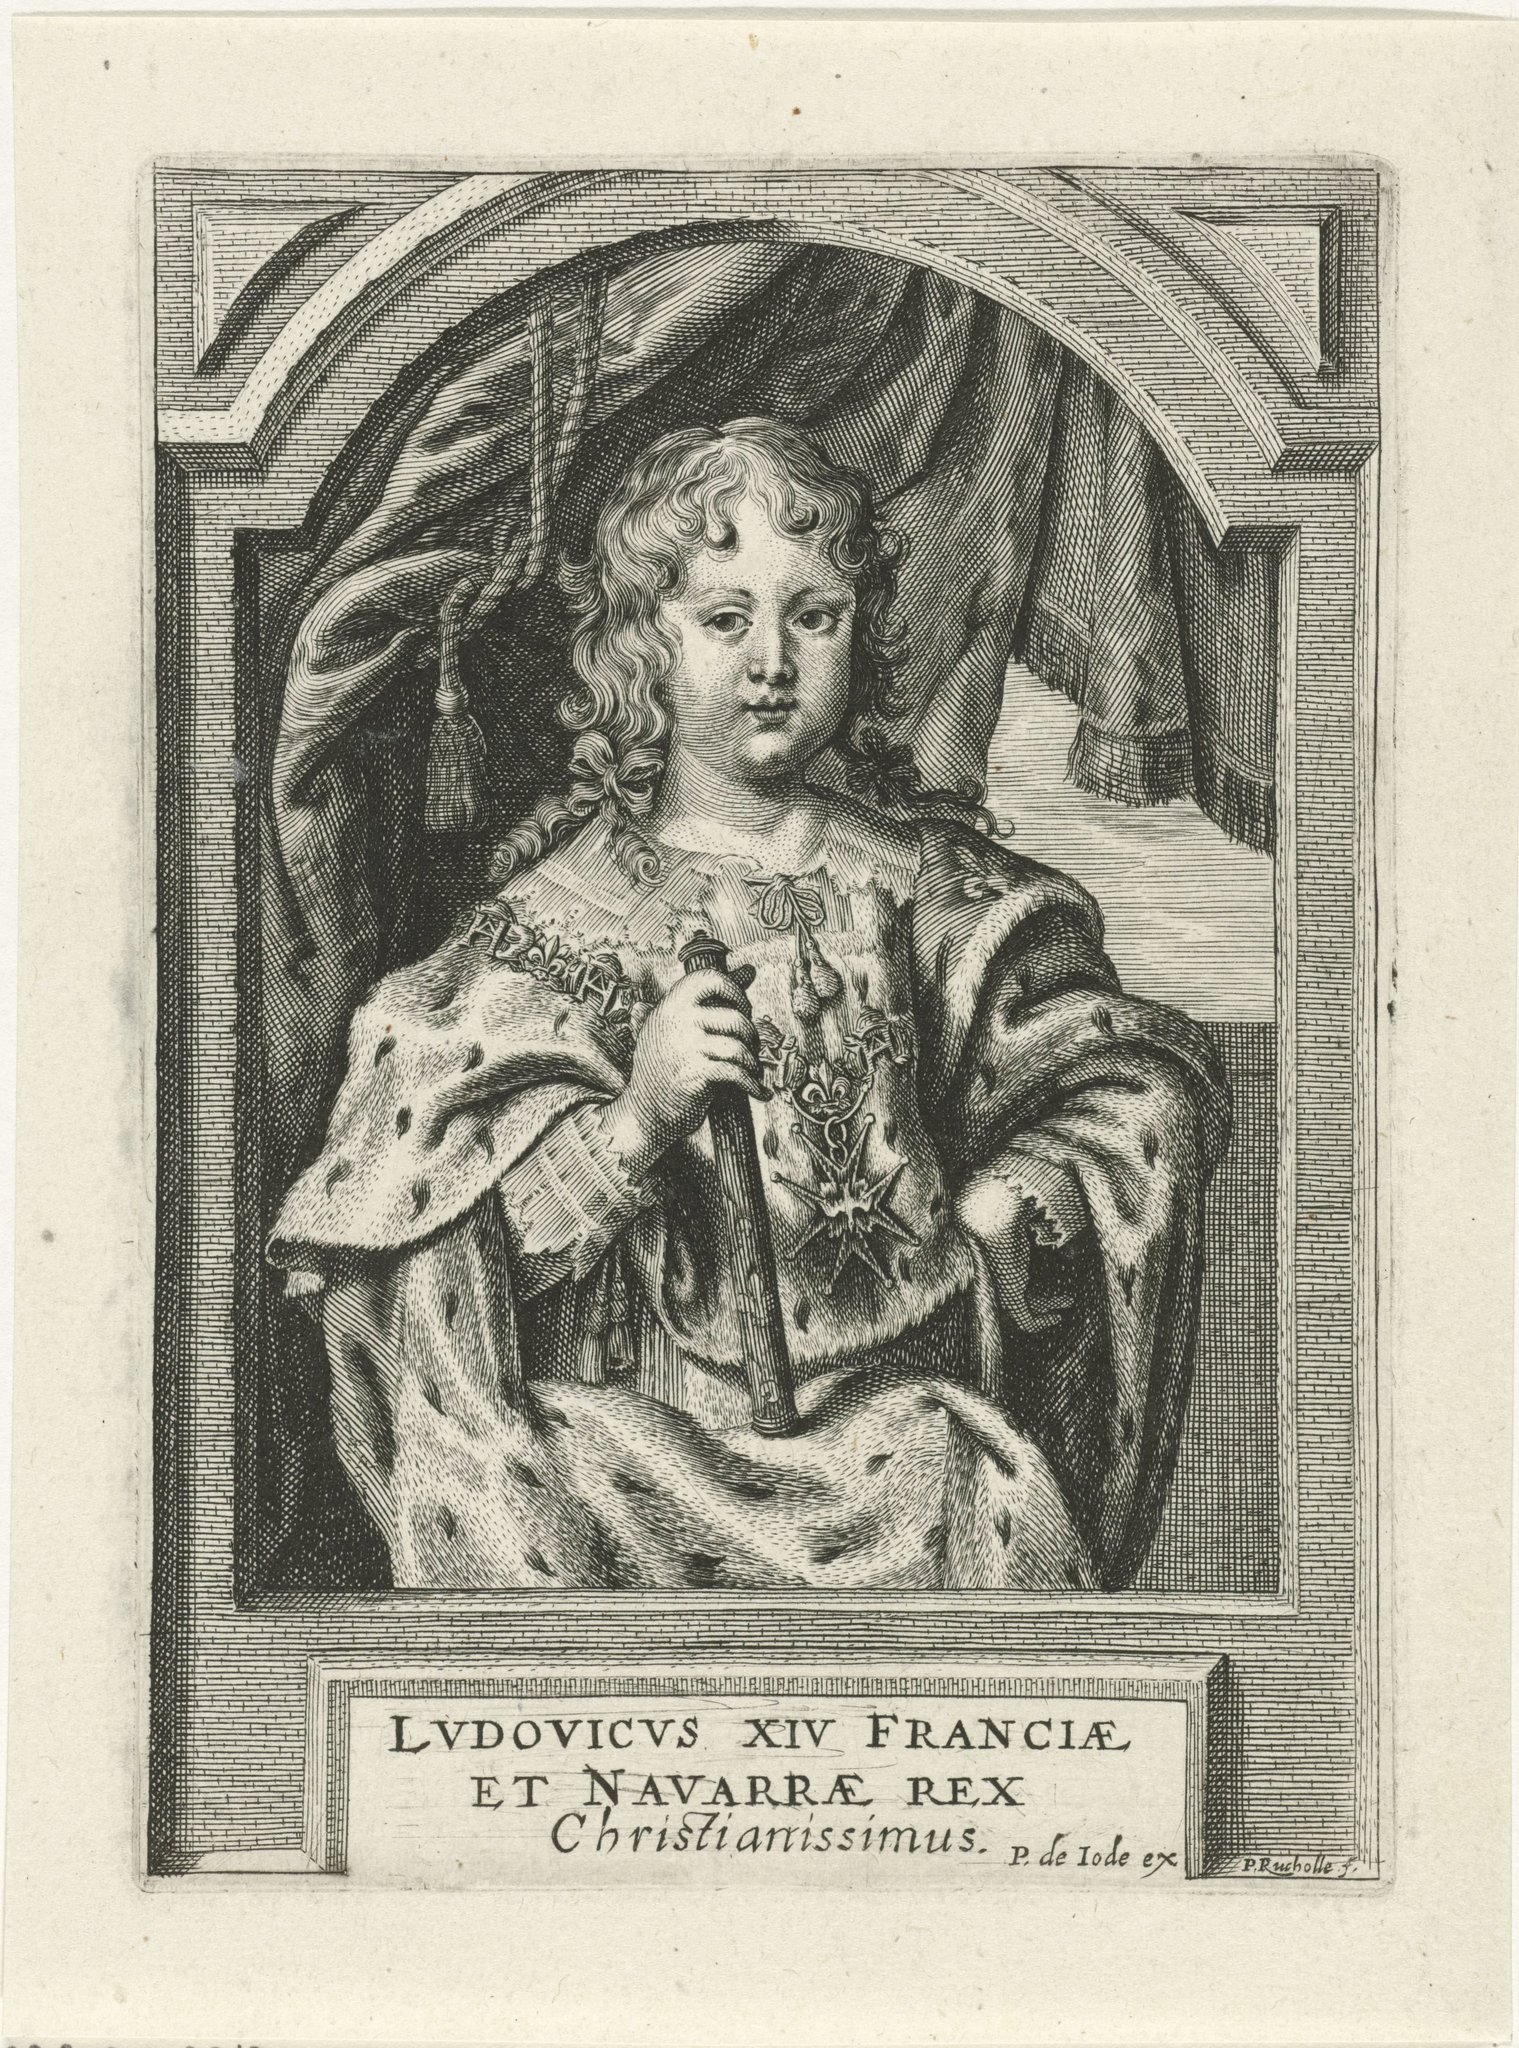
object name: print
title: Portret van Lodewijk XIV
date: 1643-1647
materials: paper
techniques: engraving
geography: antwerp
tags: lodewijk xiv (koning van frankrijk), historical persons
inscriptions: collector's mark: Lugt 2228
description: Portret van Lodewijk XIV, prins van Frankrijk, op jonge leeftijd. In de marge zijn naam en functie.